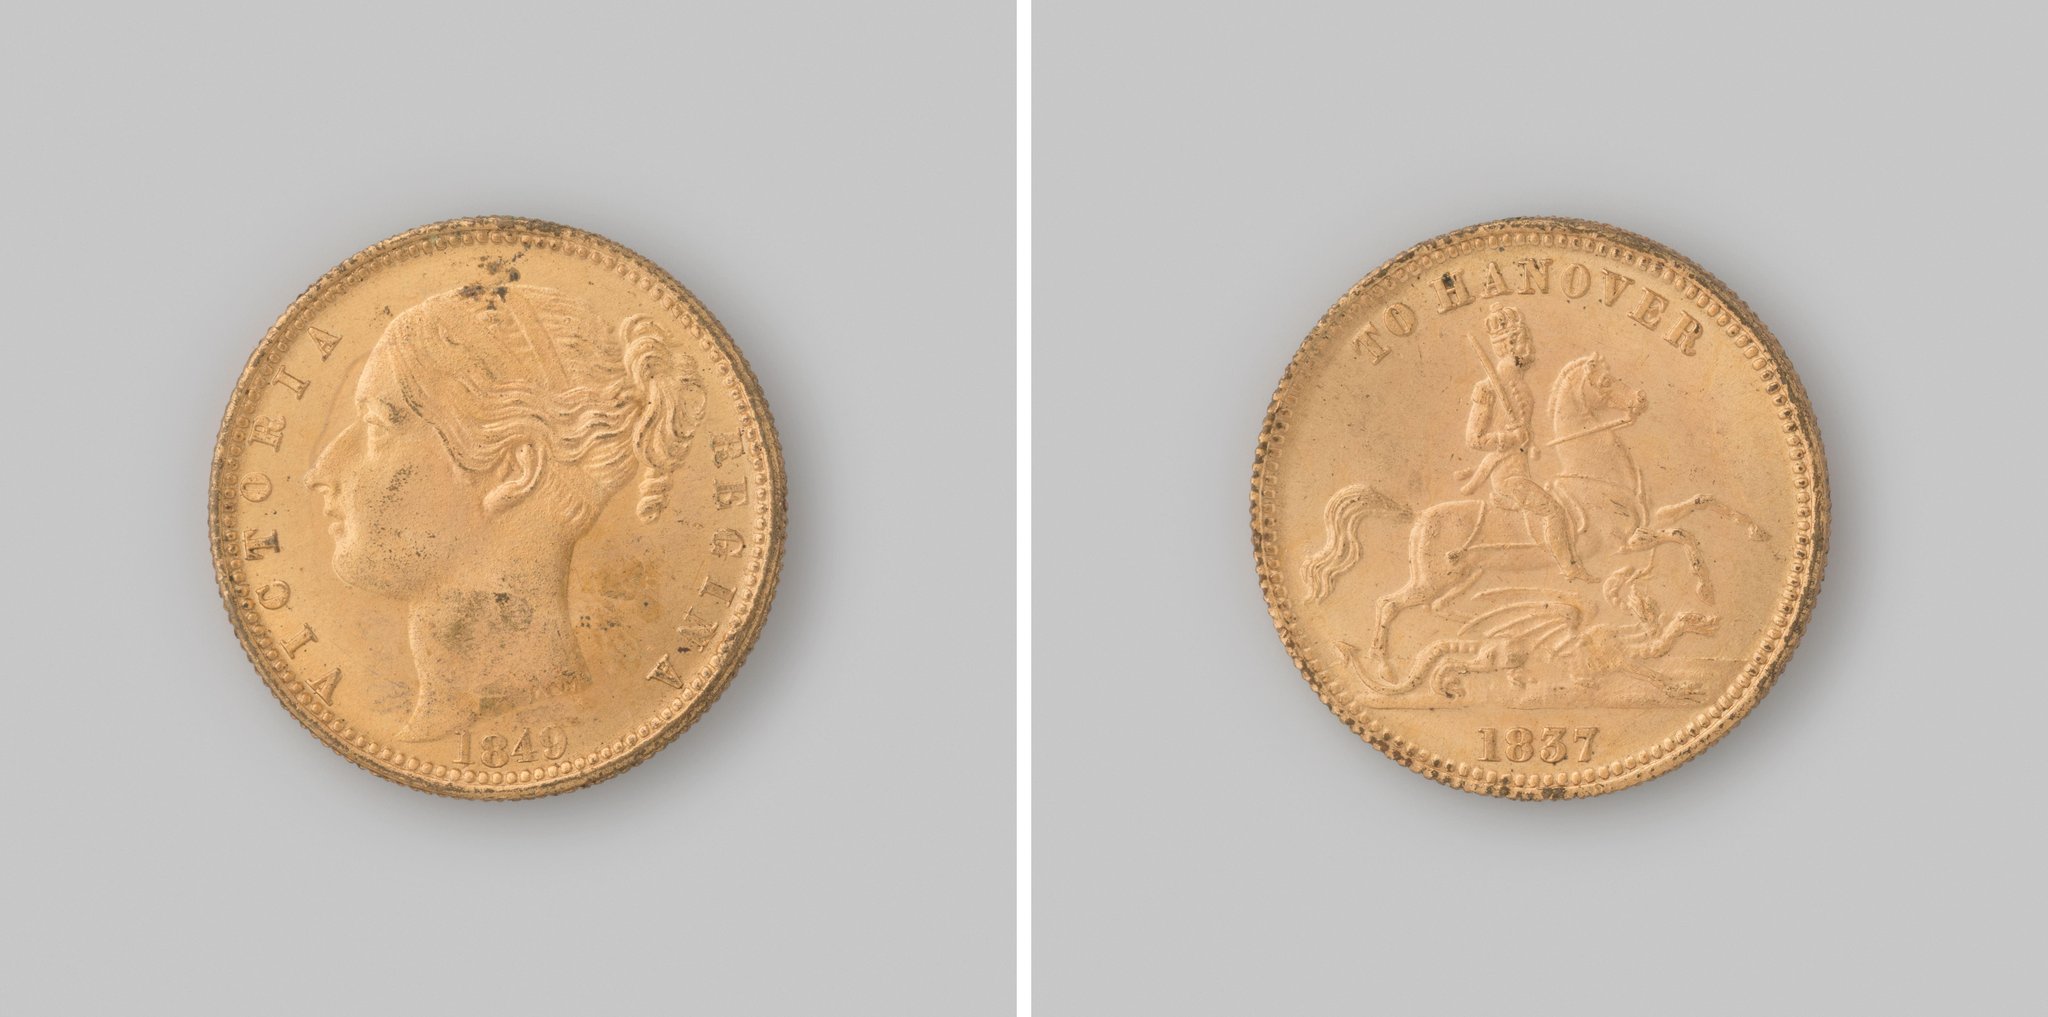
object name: history medal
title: "To Hannover" penning 1837/1849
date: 1837-1849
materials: brass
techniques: striking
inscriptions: signature: ‘A&M’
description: Messing penning met kartelrand, op de voorzijde het portret van Koningin Victoria naar links met omschrift en afsnedetekst, op de keerzijde de gekroonde Hertog van Cumberland te paard rijdend naar rechts over een draak, met omschrift en afsnedetekst.